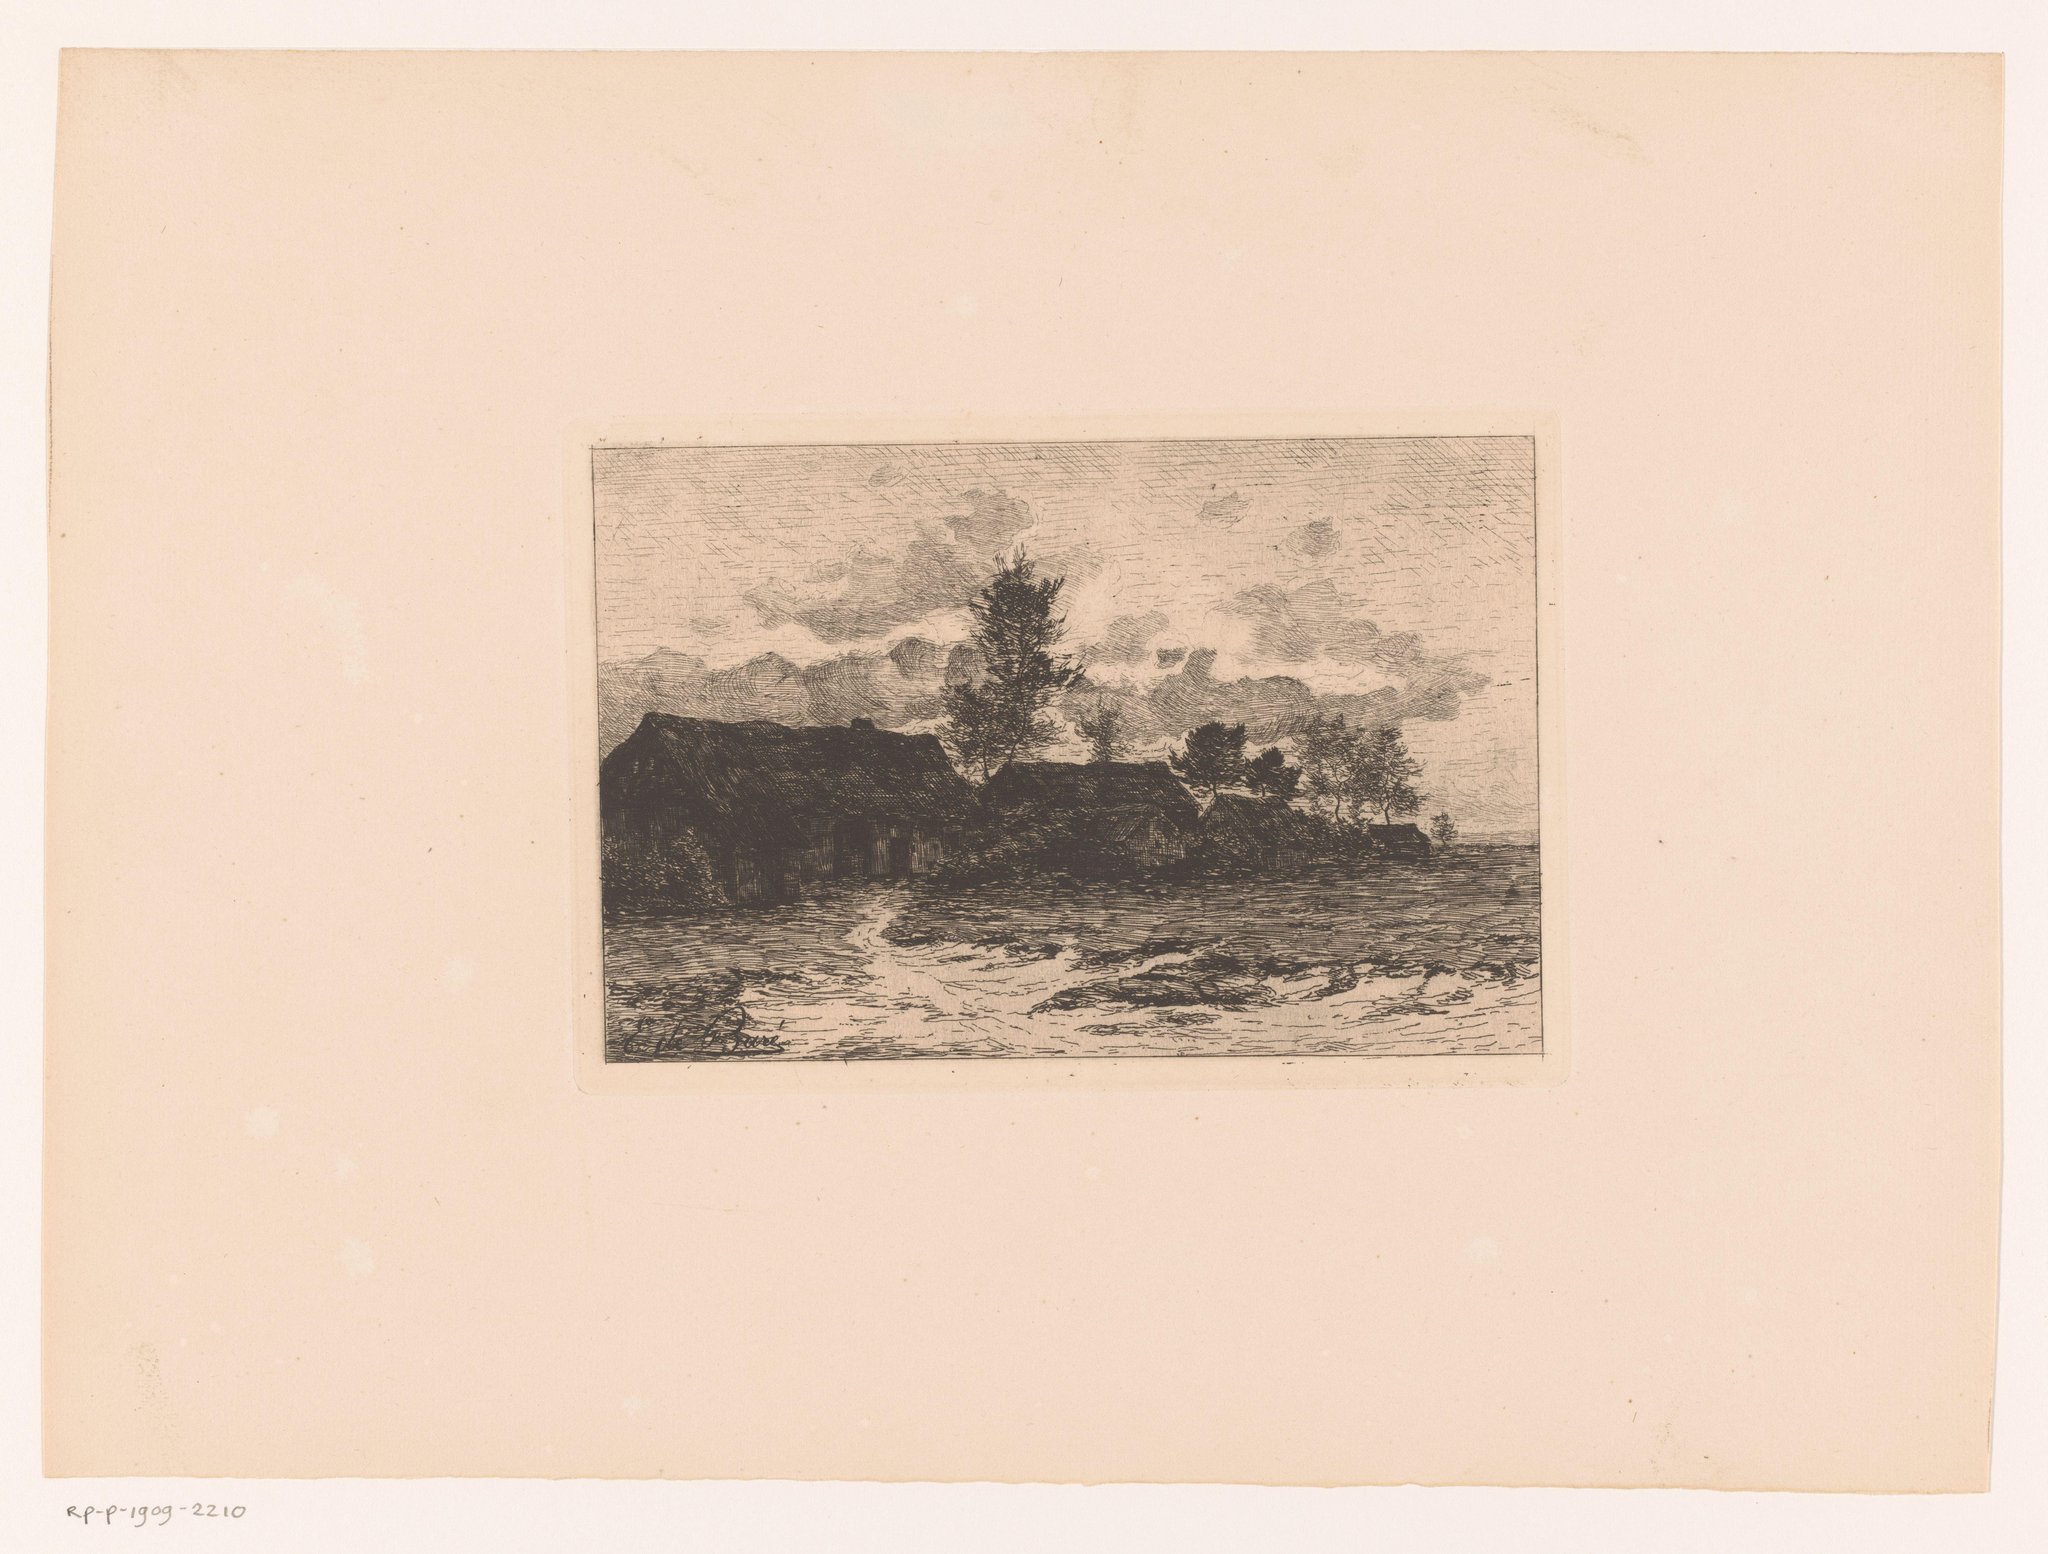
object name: print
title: Gehucht op de heide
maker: emile de baré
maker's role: painter, print maker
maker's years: 1855-1902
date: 1865-1902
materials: paper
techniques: etching, intaglio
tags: landscapes, village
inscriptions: collector's mark: Lugt 2228